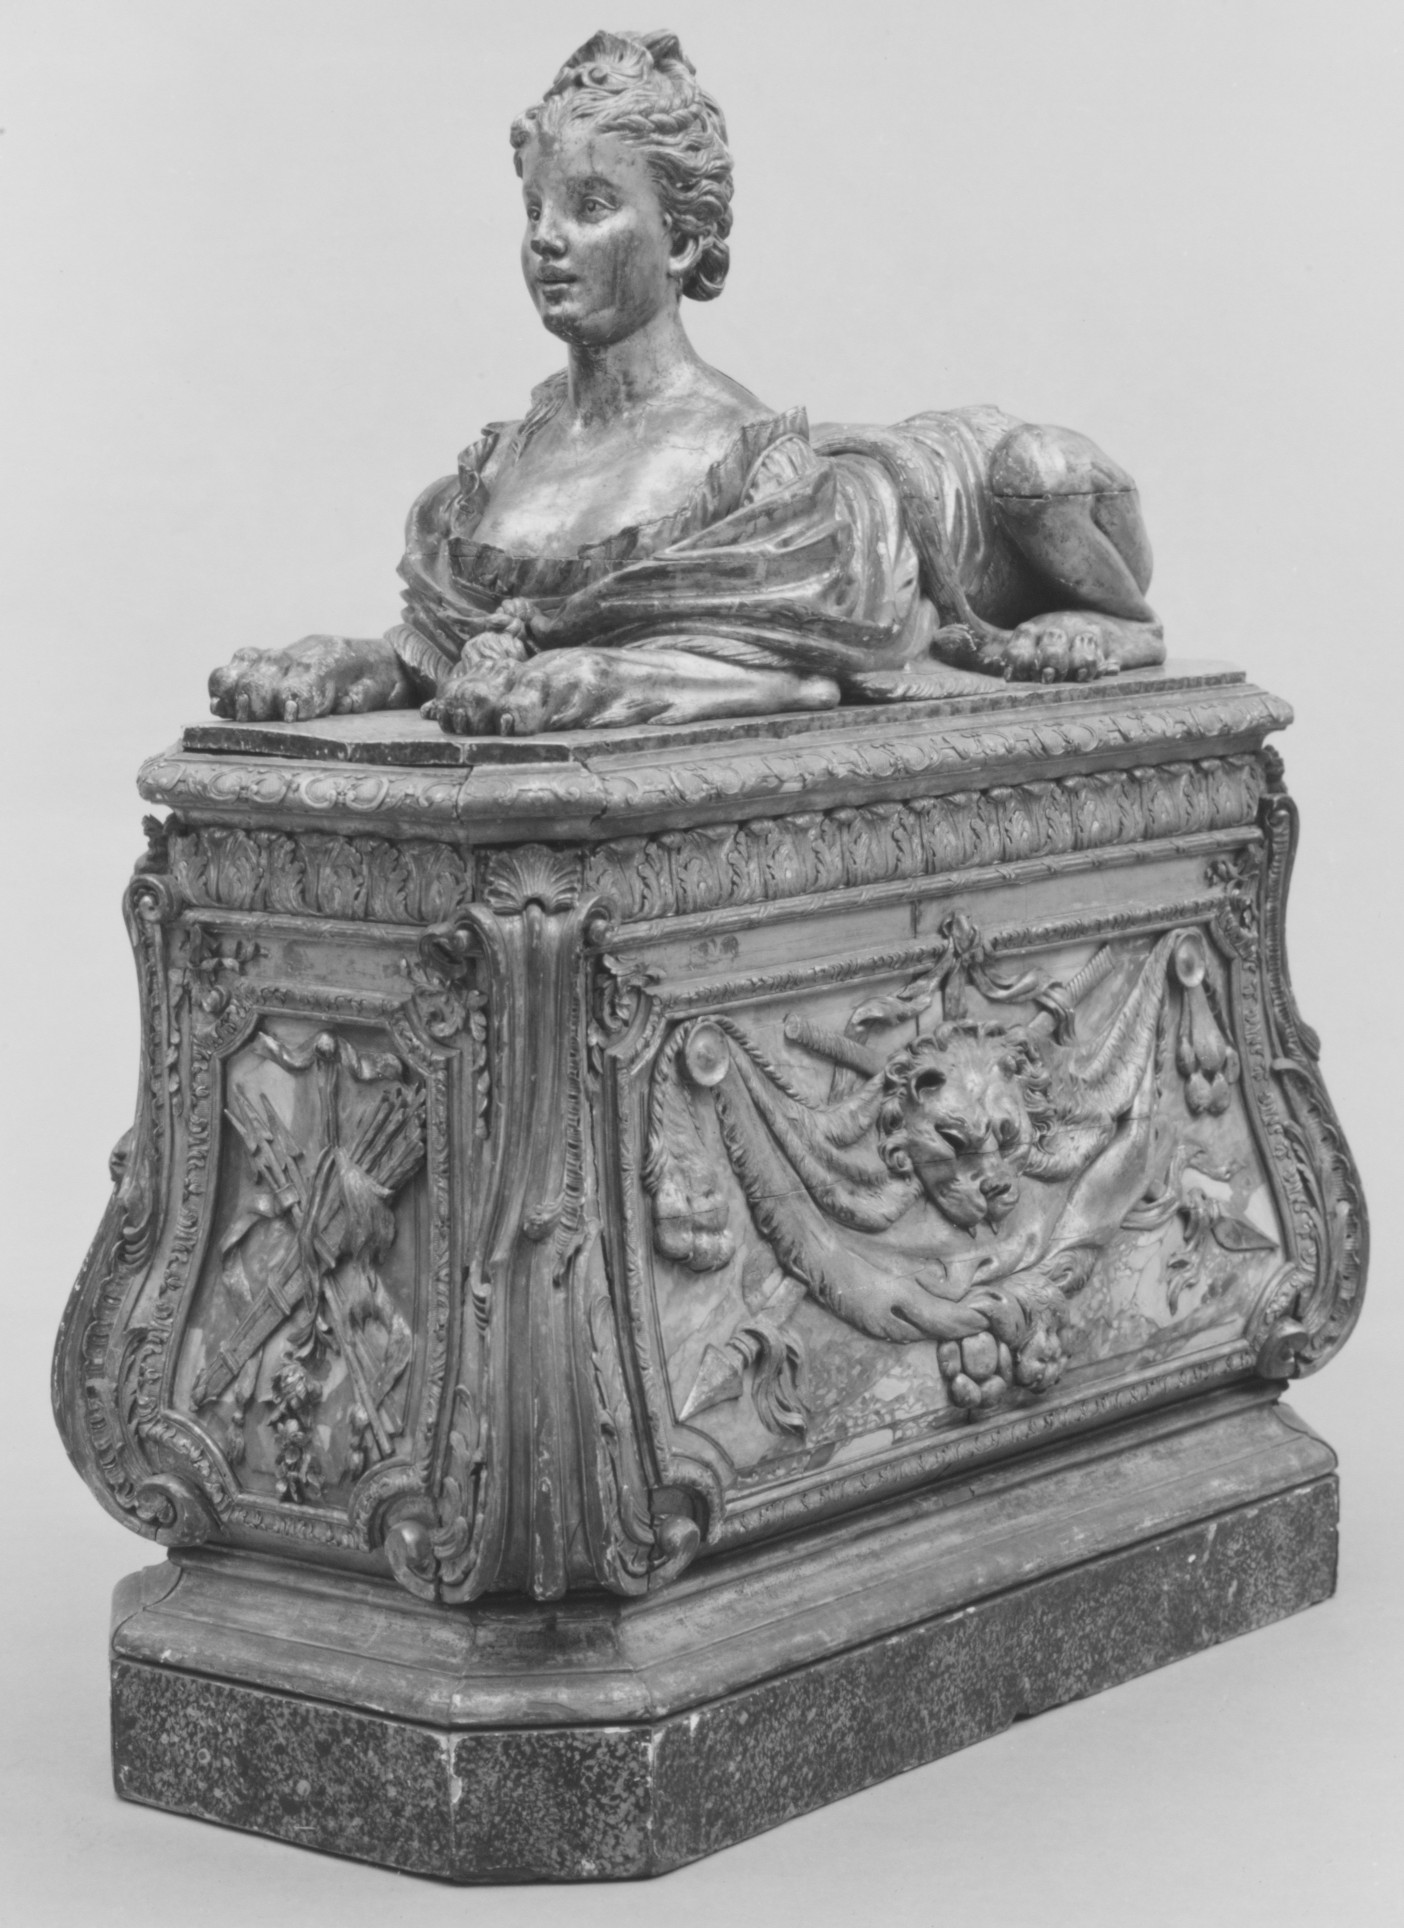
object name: pedestal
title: Sphinx (one of a pair)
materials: wood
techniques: carving, gilding, painting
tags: sphinx